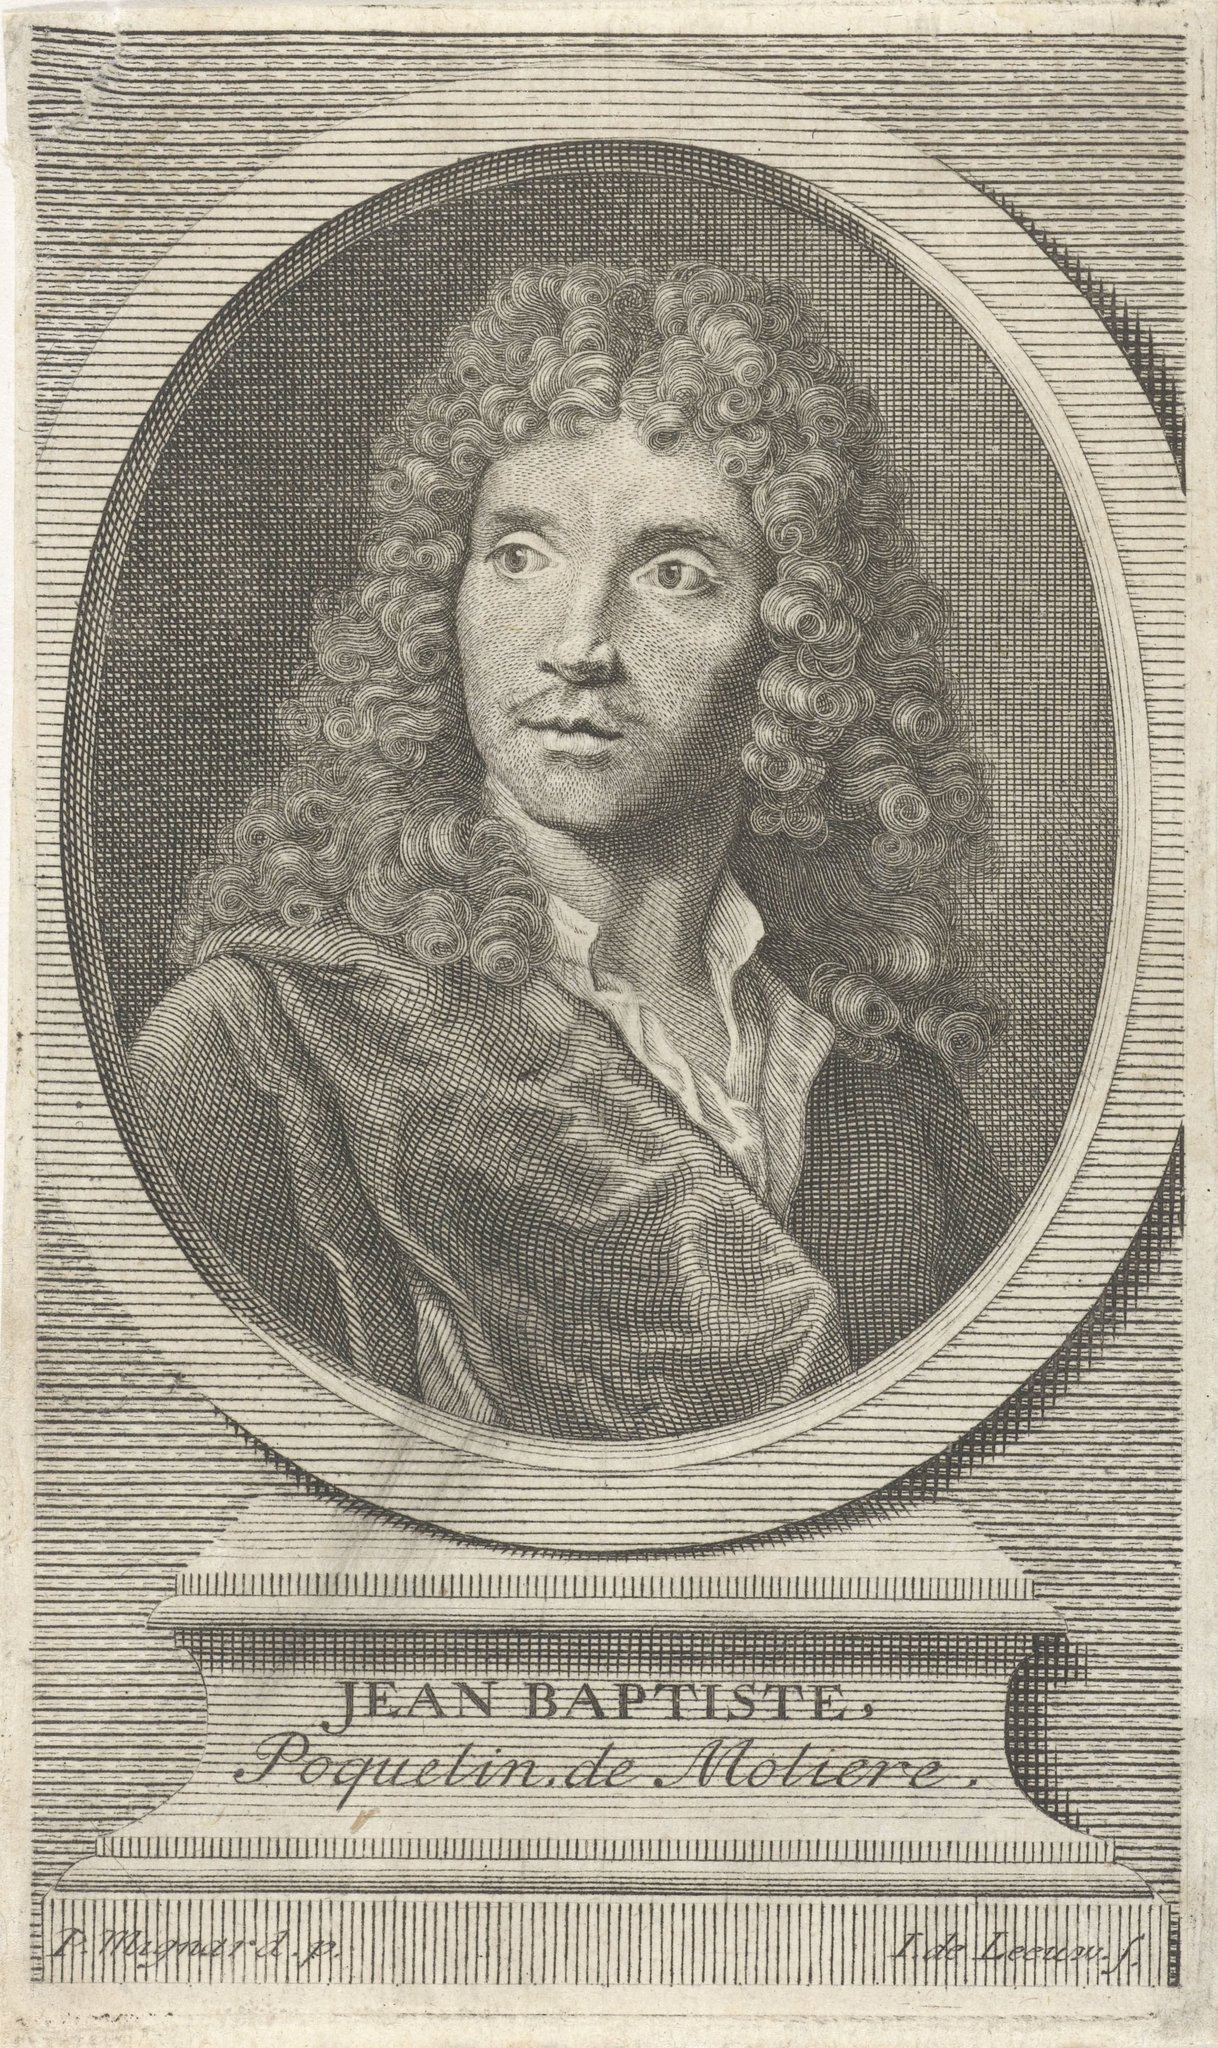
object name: print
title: Portret van Jean Baptiste Poquelin Molière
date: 1670-1770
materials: paper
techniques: engraving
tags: paris, jean baptiste poquelin molière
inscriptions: collector's mark: Lugt 2228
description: Portretbuste in ovaal naar rechts van Jean Baptiste Poquelin Molière, toneelschrijver en acteur, blootshoofds. Het portret staat op een voetstuk met naam van de geportretteerde.